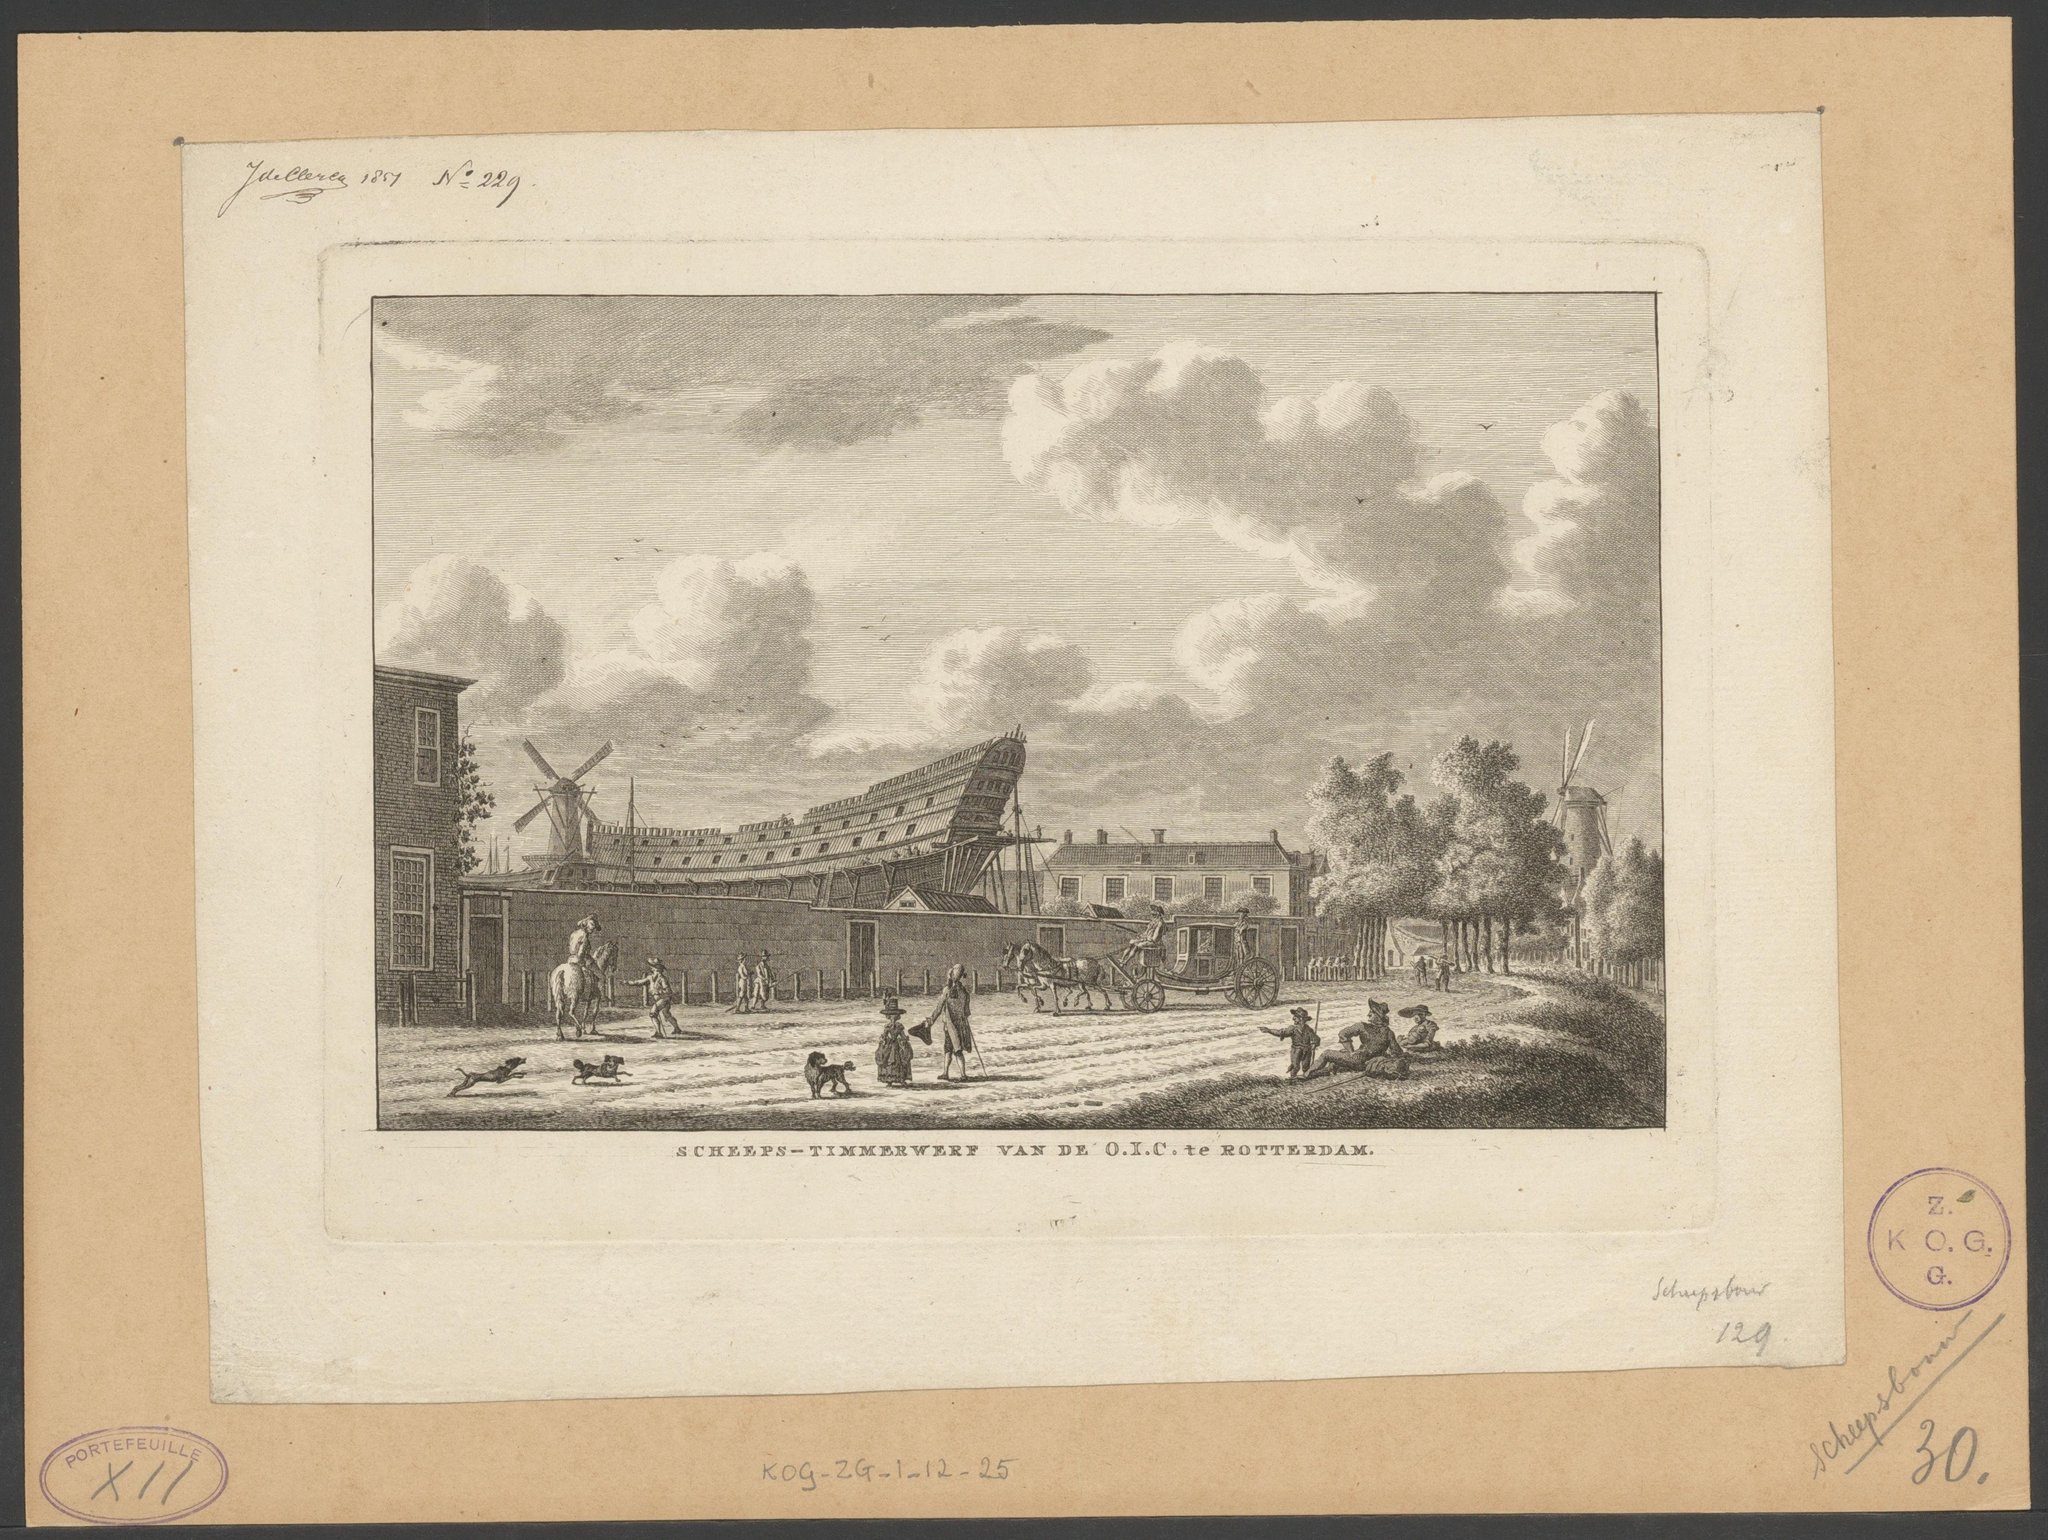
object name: print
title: Admiraliteits-magazijn te Rotterdam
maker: carel frederik bendorp (i)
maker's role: print maker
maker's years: 1736-1814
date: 1786-1792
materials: paper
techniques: engraving, etching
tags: large-scale structure for storage, e.g.: warehouse, depot, silo, trade-company, building a ship, ship under construction, windmill in landscape, shipyard, shipdock, rotterdam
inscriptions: stamp, collector's mark: Lugt 1641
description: Prent mogelijk uit: Vaderlandsche gezichten, of afbeeldingen van den tegenwoordigen staat der Vereenigde Nederlanden (…). Amsterdam: Hendrik Gartman, Willem Vermandel en Jan Willem Smit, 1786-1792. Uitgegeven in afleveringen met ieder een eigen bifolium en inhoudsopgave. Alle prenten in deze publicatie zijn gegraveerd door Carel Frederik Bendorp (I) en, in de meeste gevallen, gebaseerd op tekeningen van Jan Bulthuis. Latere staat van prent uitgegeven als onderdeel van een plaatwerk uit ca. 1824-1825 met 74 (ongenummerde) platen van de belangrijkste topografische gezichten en verschillende zeden en gewoonten in het Verenigd Koninkrijk der Nederlanden, getiteld 'Tableau des principales vues des palais et édifices : représentations et des coutumes et usages, dans les provinces septentrionales du Royaume des Pays-Bas'.